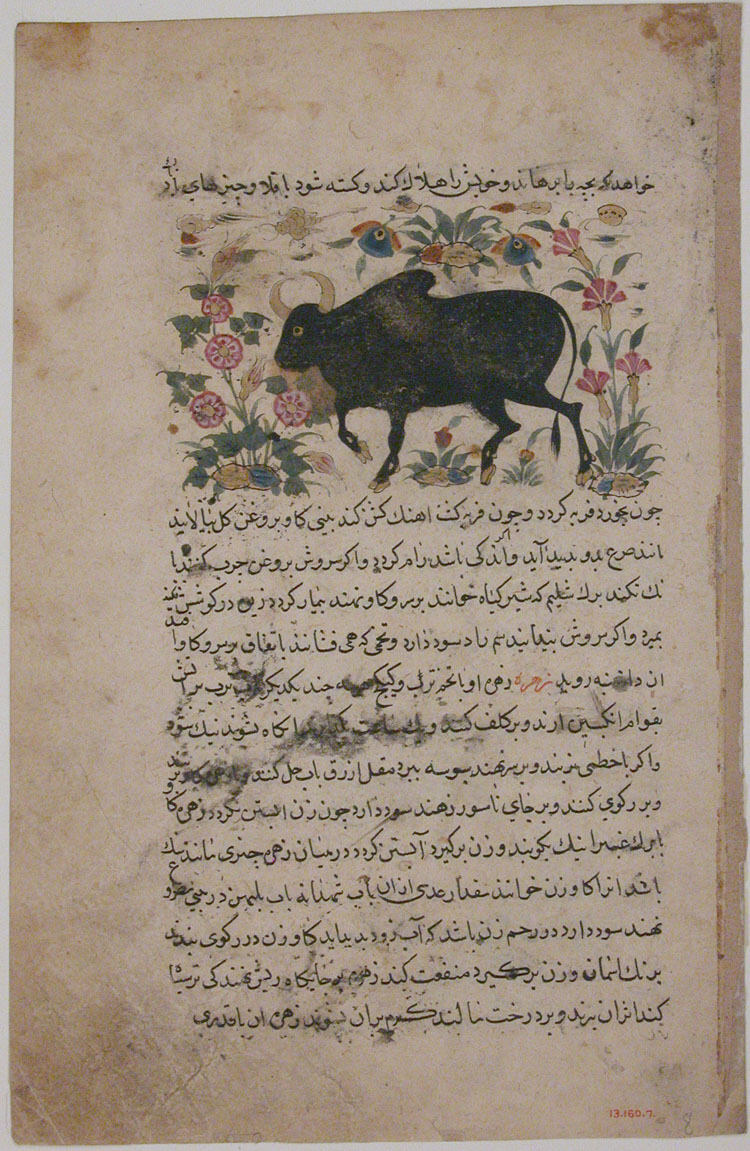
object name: folio from an illustrated manuscript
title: "A Bull", Folio from a Dispersed Nuzhatnama-i ‘Ala’i of Shahmardan ibn Abi’l Khayr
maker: shamardan ibn abi 'l khayr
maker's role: author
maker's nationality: iranian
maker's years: 1075-1125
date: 1401-1433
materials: gold, ink, paper, watercolor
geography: iran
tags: bulls,flowers